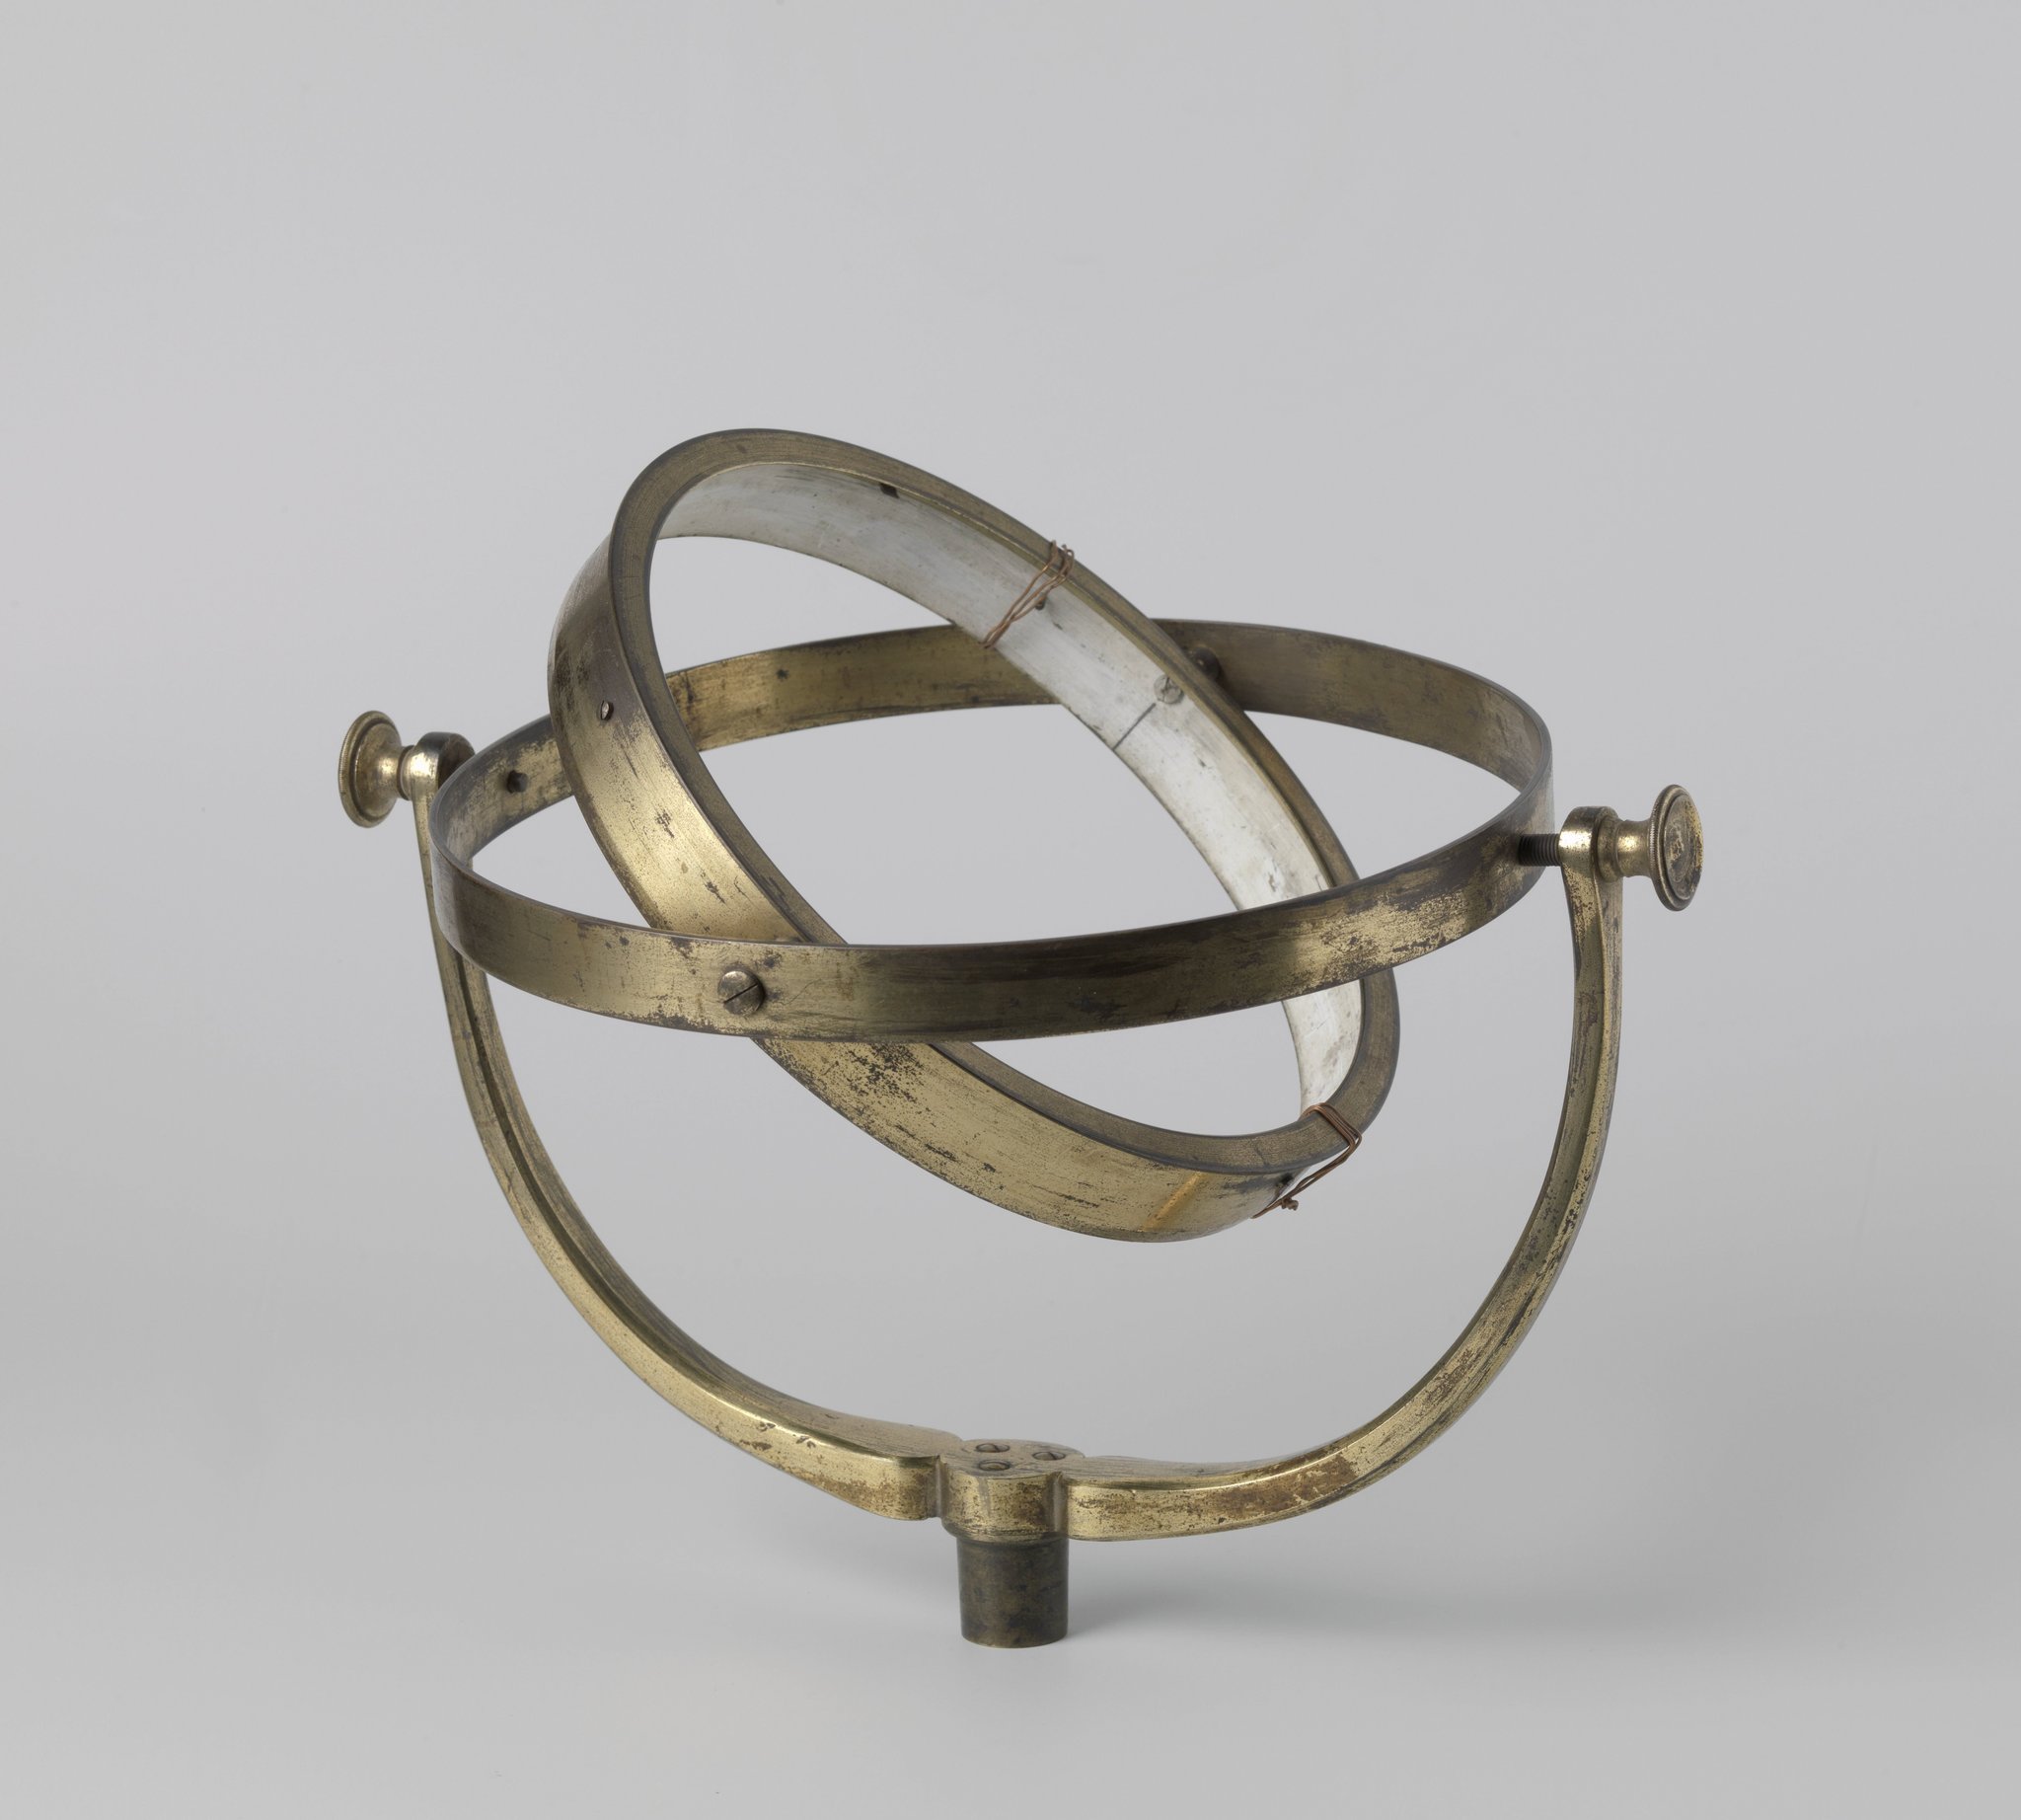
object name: cardanusring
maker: Anonymous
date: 1850-1899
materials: brass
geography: netherlands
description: Messing houder met twee concentrische ringen. In de binnenste ring kon een kompas worden gehangen dat altijd horizontaal wordt gehouden doordat de cardanusring de rollende beweging van het schip compenseert.